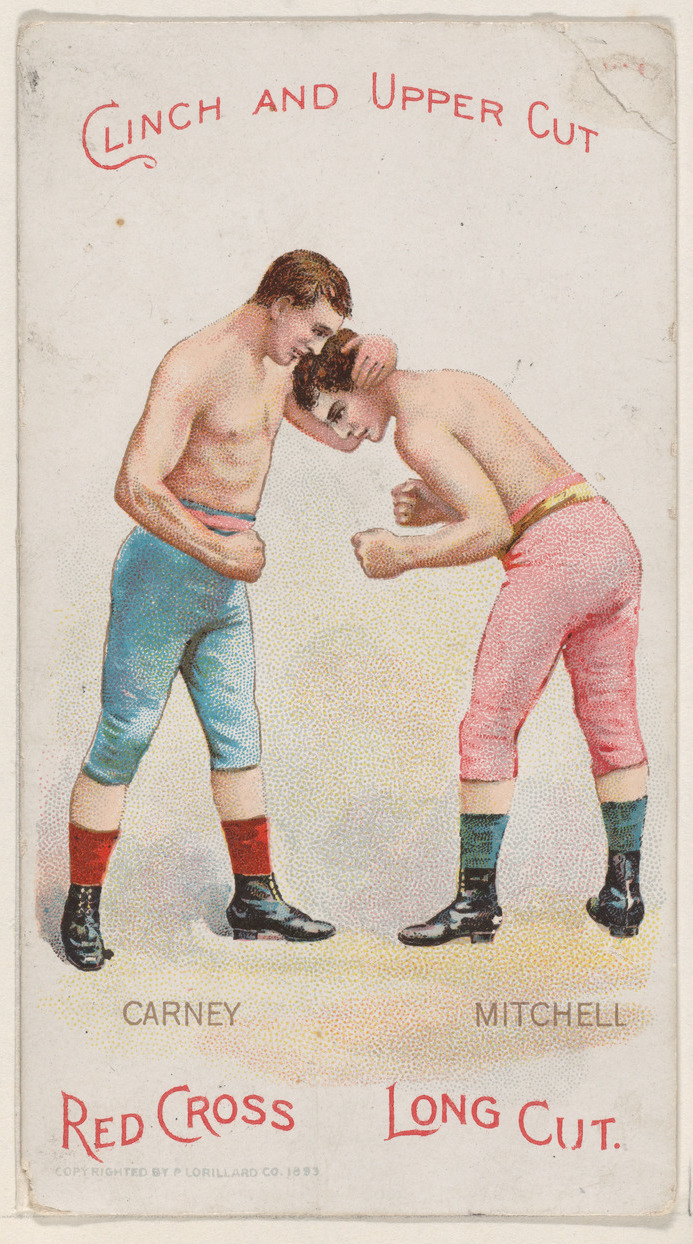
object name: print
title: Clinch and Upper Cut, Jemmy Carney and Jemmy Mitchell, from the Boxing Positions and Boxers series (N266) issued by P. Lorillard Company to promote Red Cross Long Cut Tobacco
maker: p. lorillard company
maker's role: publisher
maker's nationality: american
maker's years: 1760-2014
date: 1893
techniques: color lithograph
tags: men,boxing,athletes